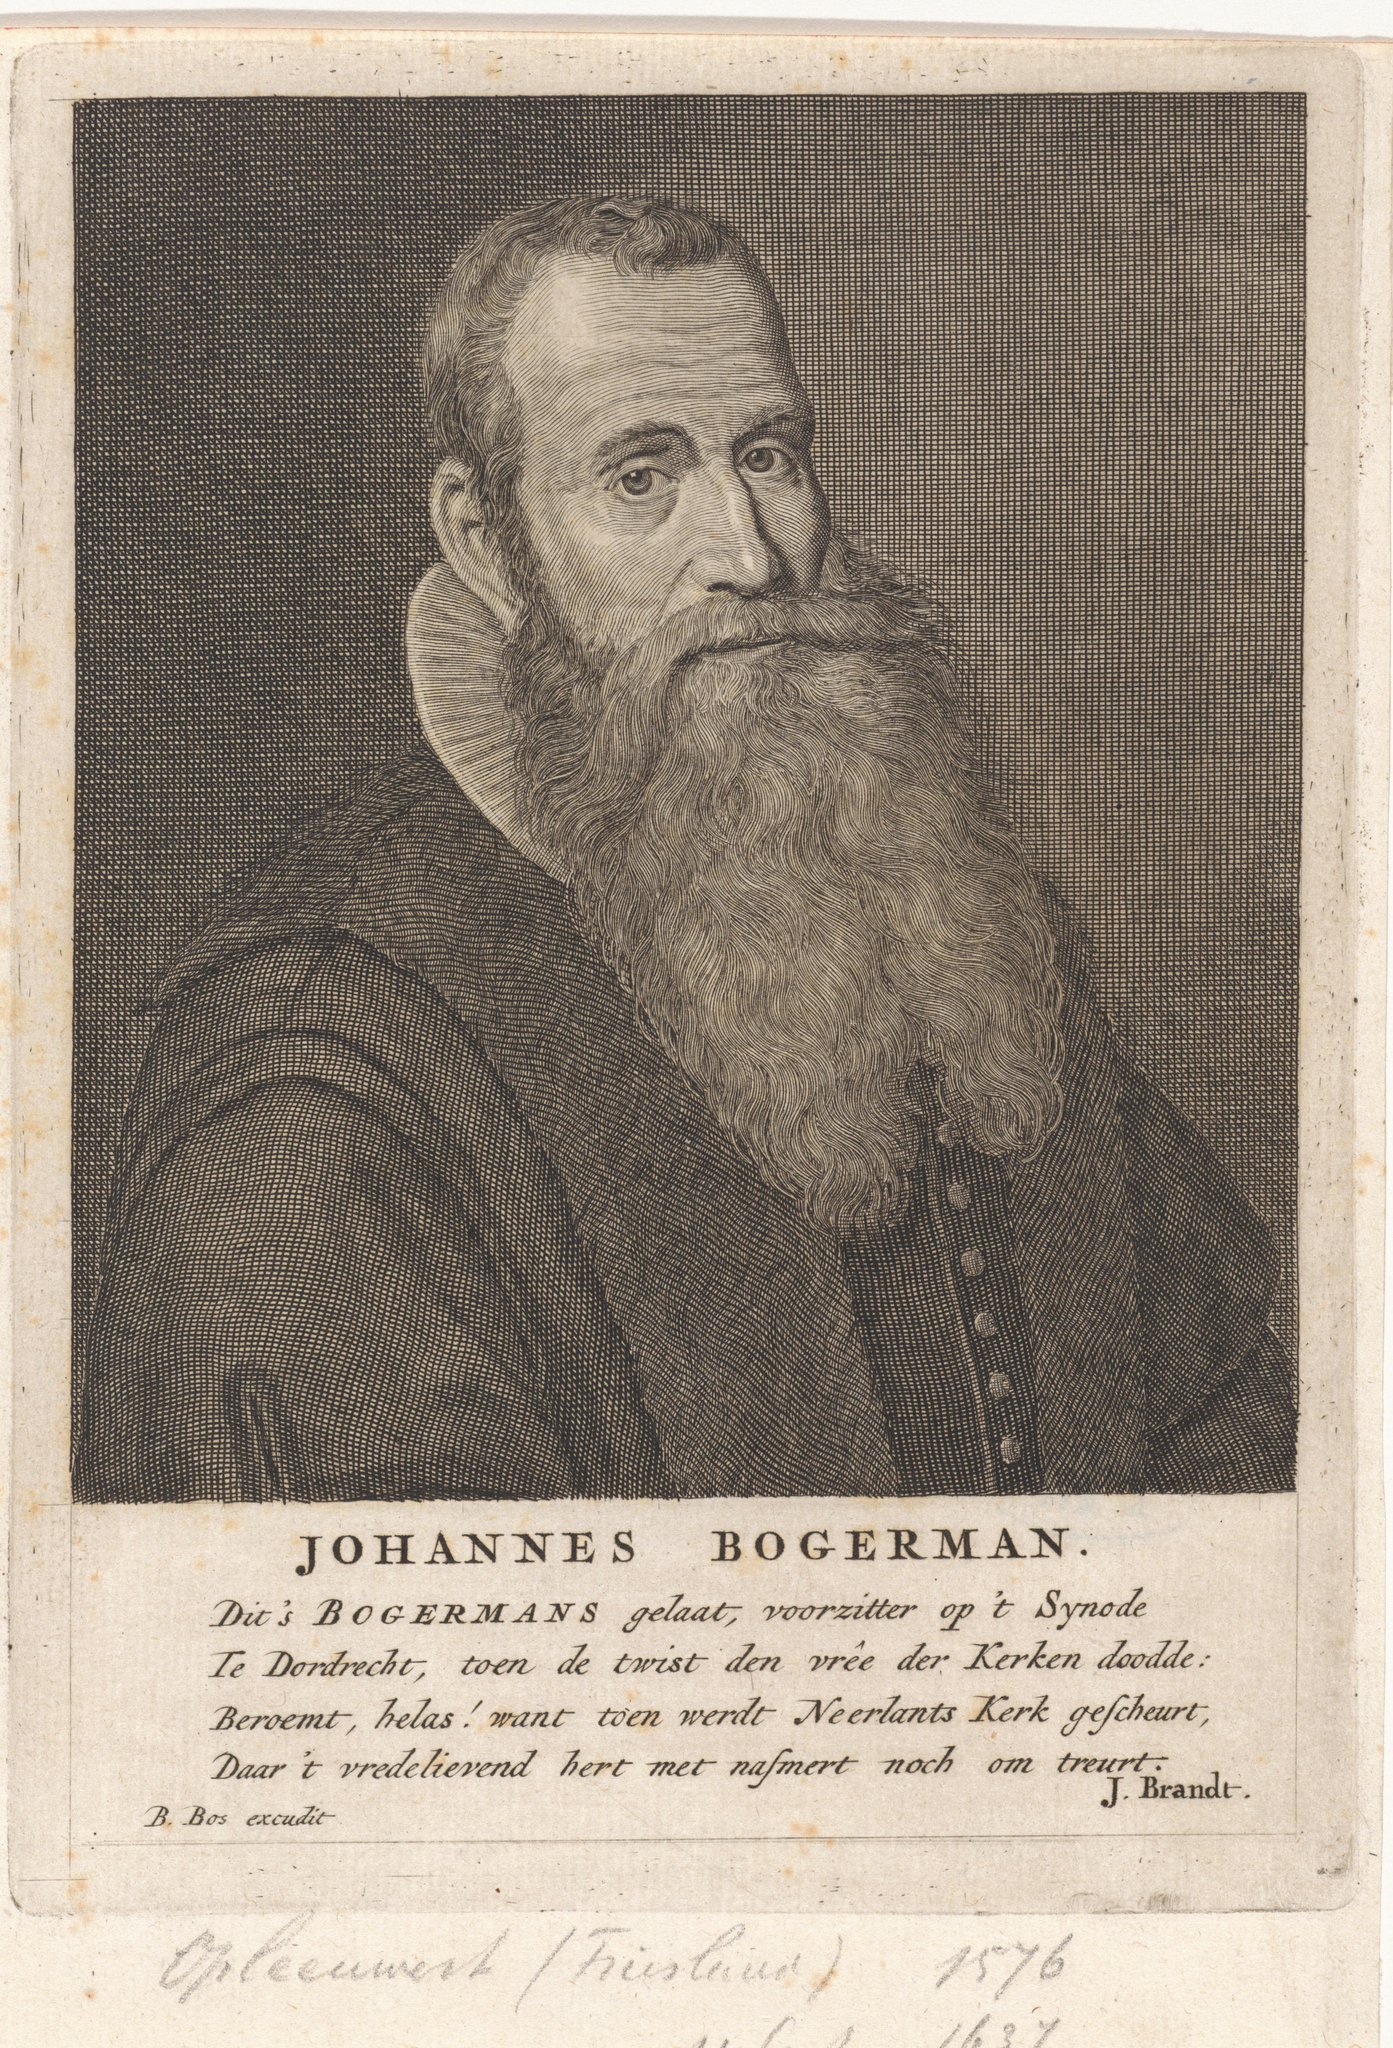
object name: print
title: Portret van Johannes Bogerman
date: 1704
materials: paper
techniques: engraving, etching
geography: rotterdam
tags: predikant, johannes bogerman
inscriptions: collector's mark: Lugt 2228, inscription: ‘Opleeuwert (Friesland) 1576 / (?) 1637’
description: Prent ook gebruikt in: G. Brandts Historie der Reformatie, en andre kerkelyke geschiedenissen, in en ontrent de Nederlanden. Het derde deel. Rotterdam: Barent Bos, 1704, tussen p. 298 en 299.